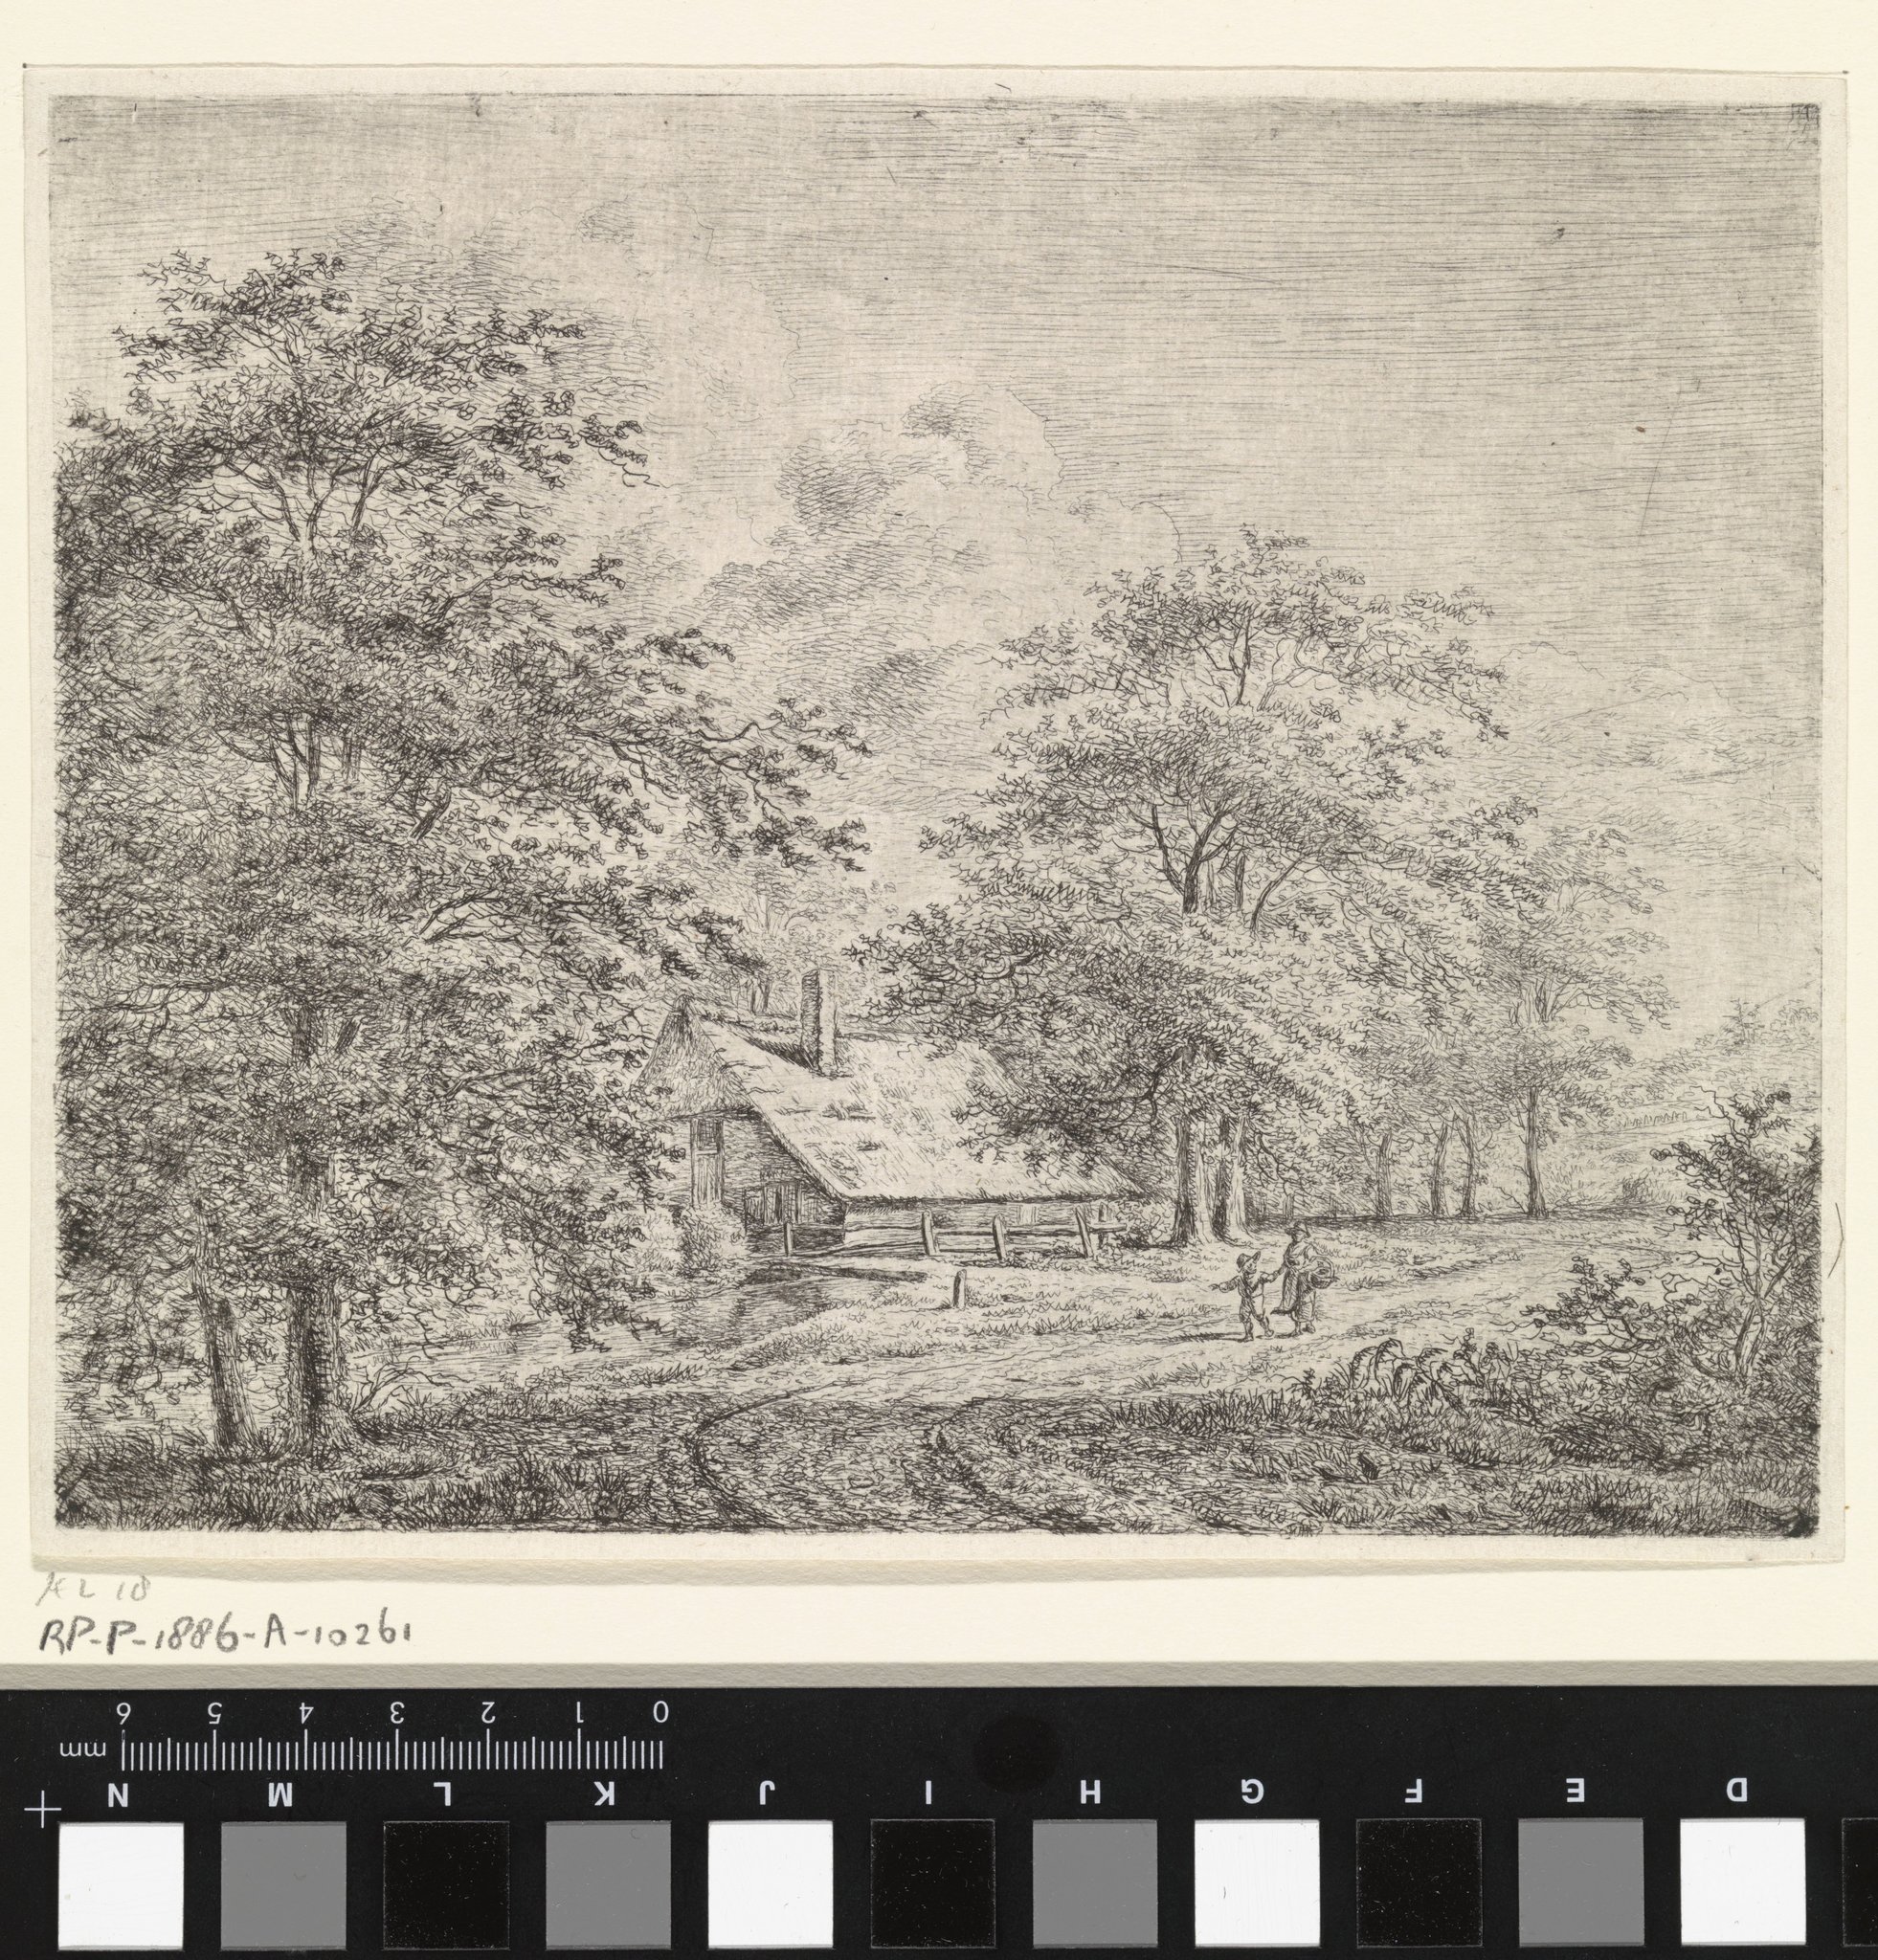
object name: print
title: Bosrijk landschap met vrouw en kind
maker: pieter janson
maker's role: draughtsman, print maker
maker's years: 1765-1851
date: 1780-1851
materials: paper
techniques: etching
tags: mother and baby or young child, farm or solitary house in landscape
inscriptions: collector's mark: Lugt 2228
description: Bosrijk landschap met landweg langs een boerderij. Op de weg loopt een vrouw met een mand aan haar linkerarm en een kind bij de hand.